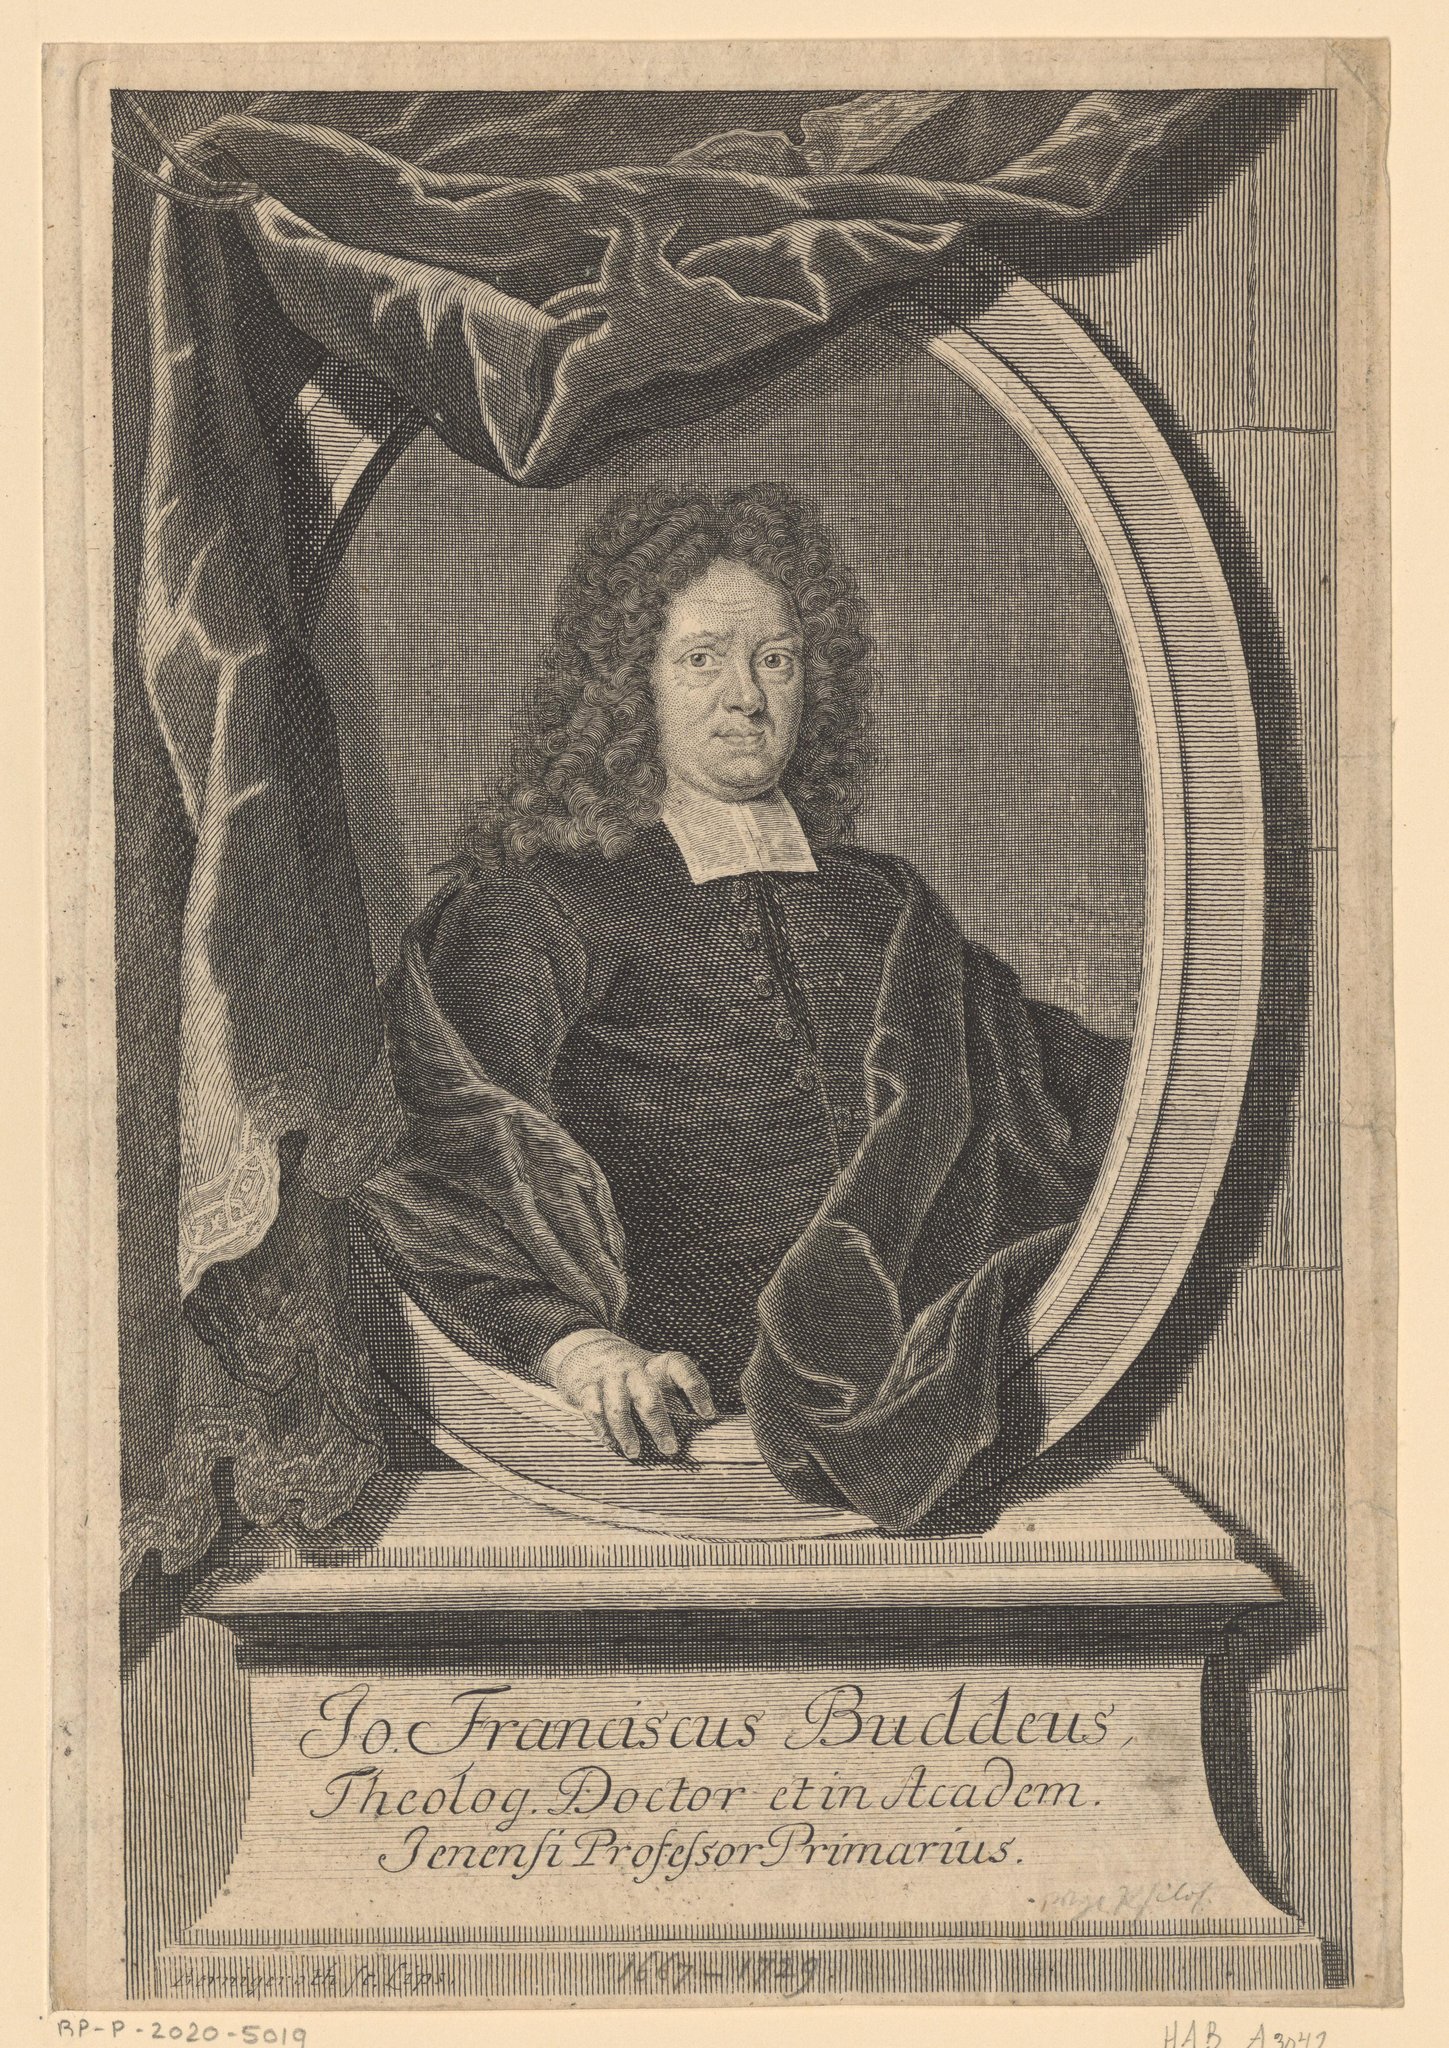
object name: print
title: Portret van Johann Franz Buddeus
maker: martin bernigeroth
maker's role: print maker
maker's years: 1670-1733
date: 1700-1733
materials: paper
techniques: engraving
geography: leipzig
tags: theologian, historical persons